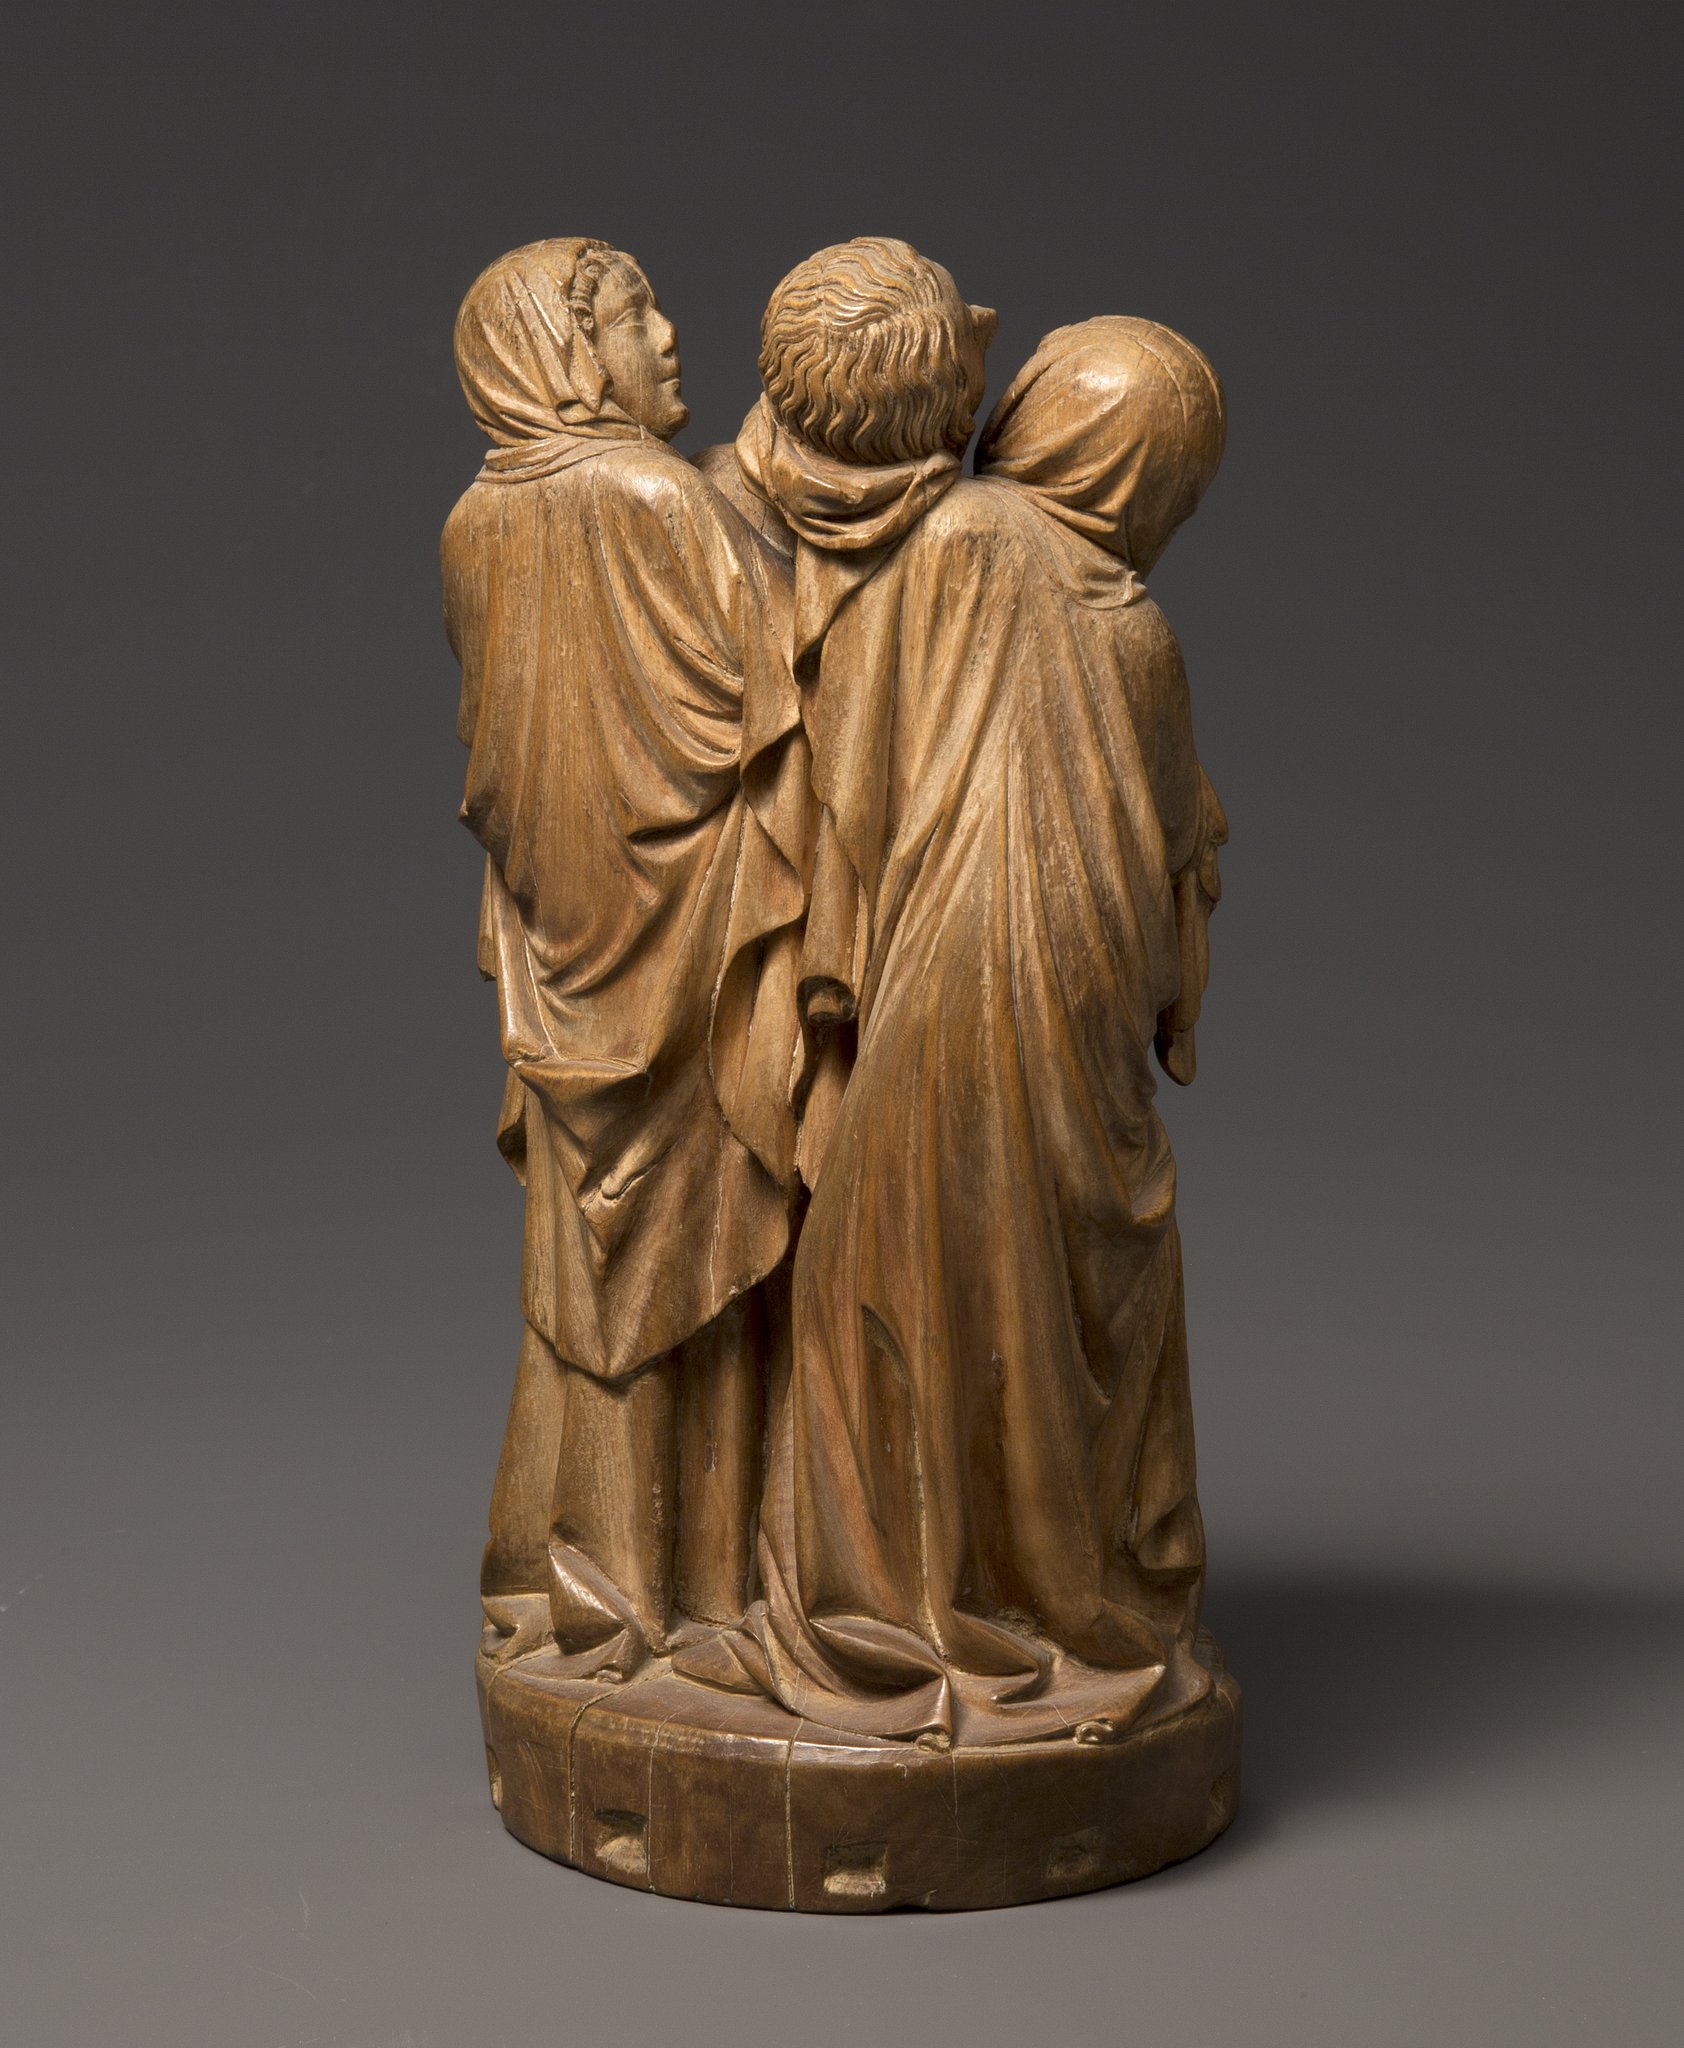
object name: sculpture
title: The Three Maries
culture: french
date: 1367-1400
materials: wood